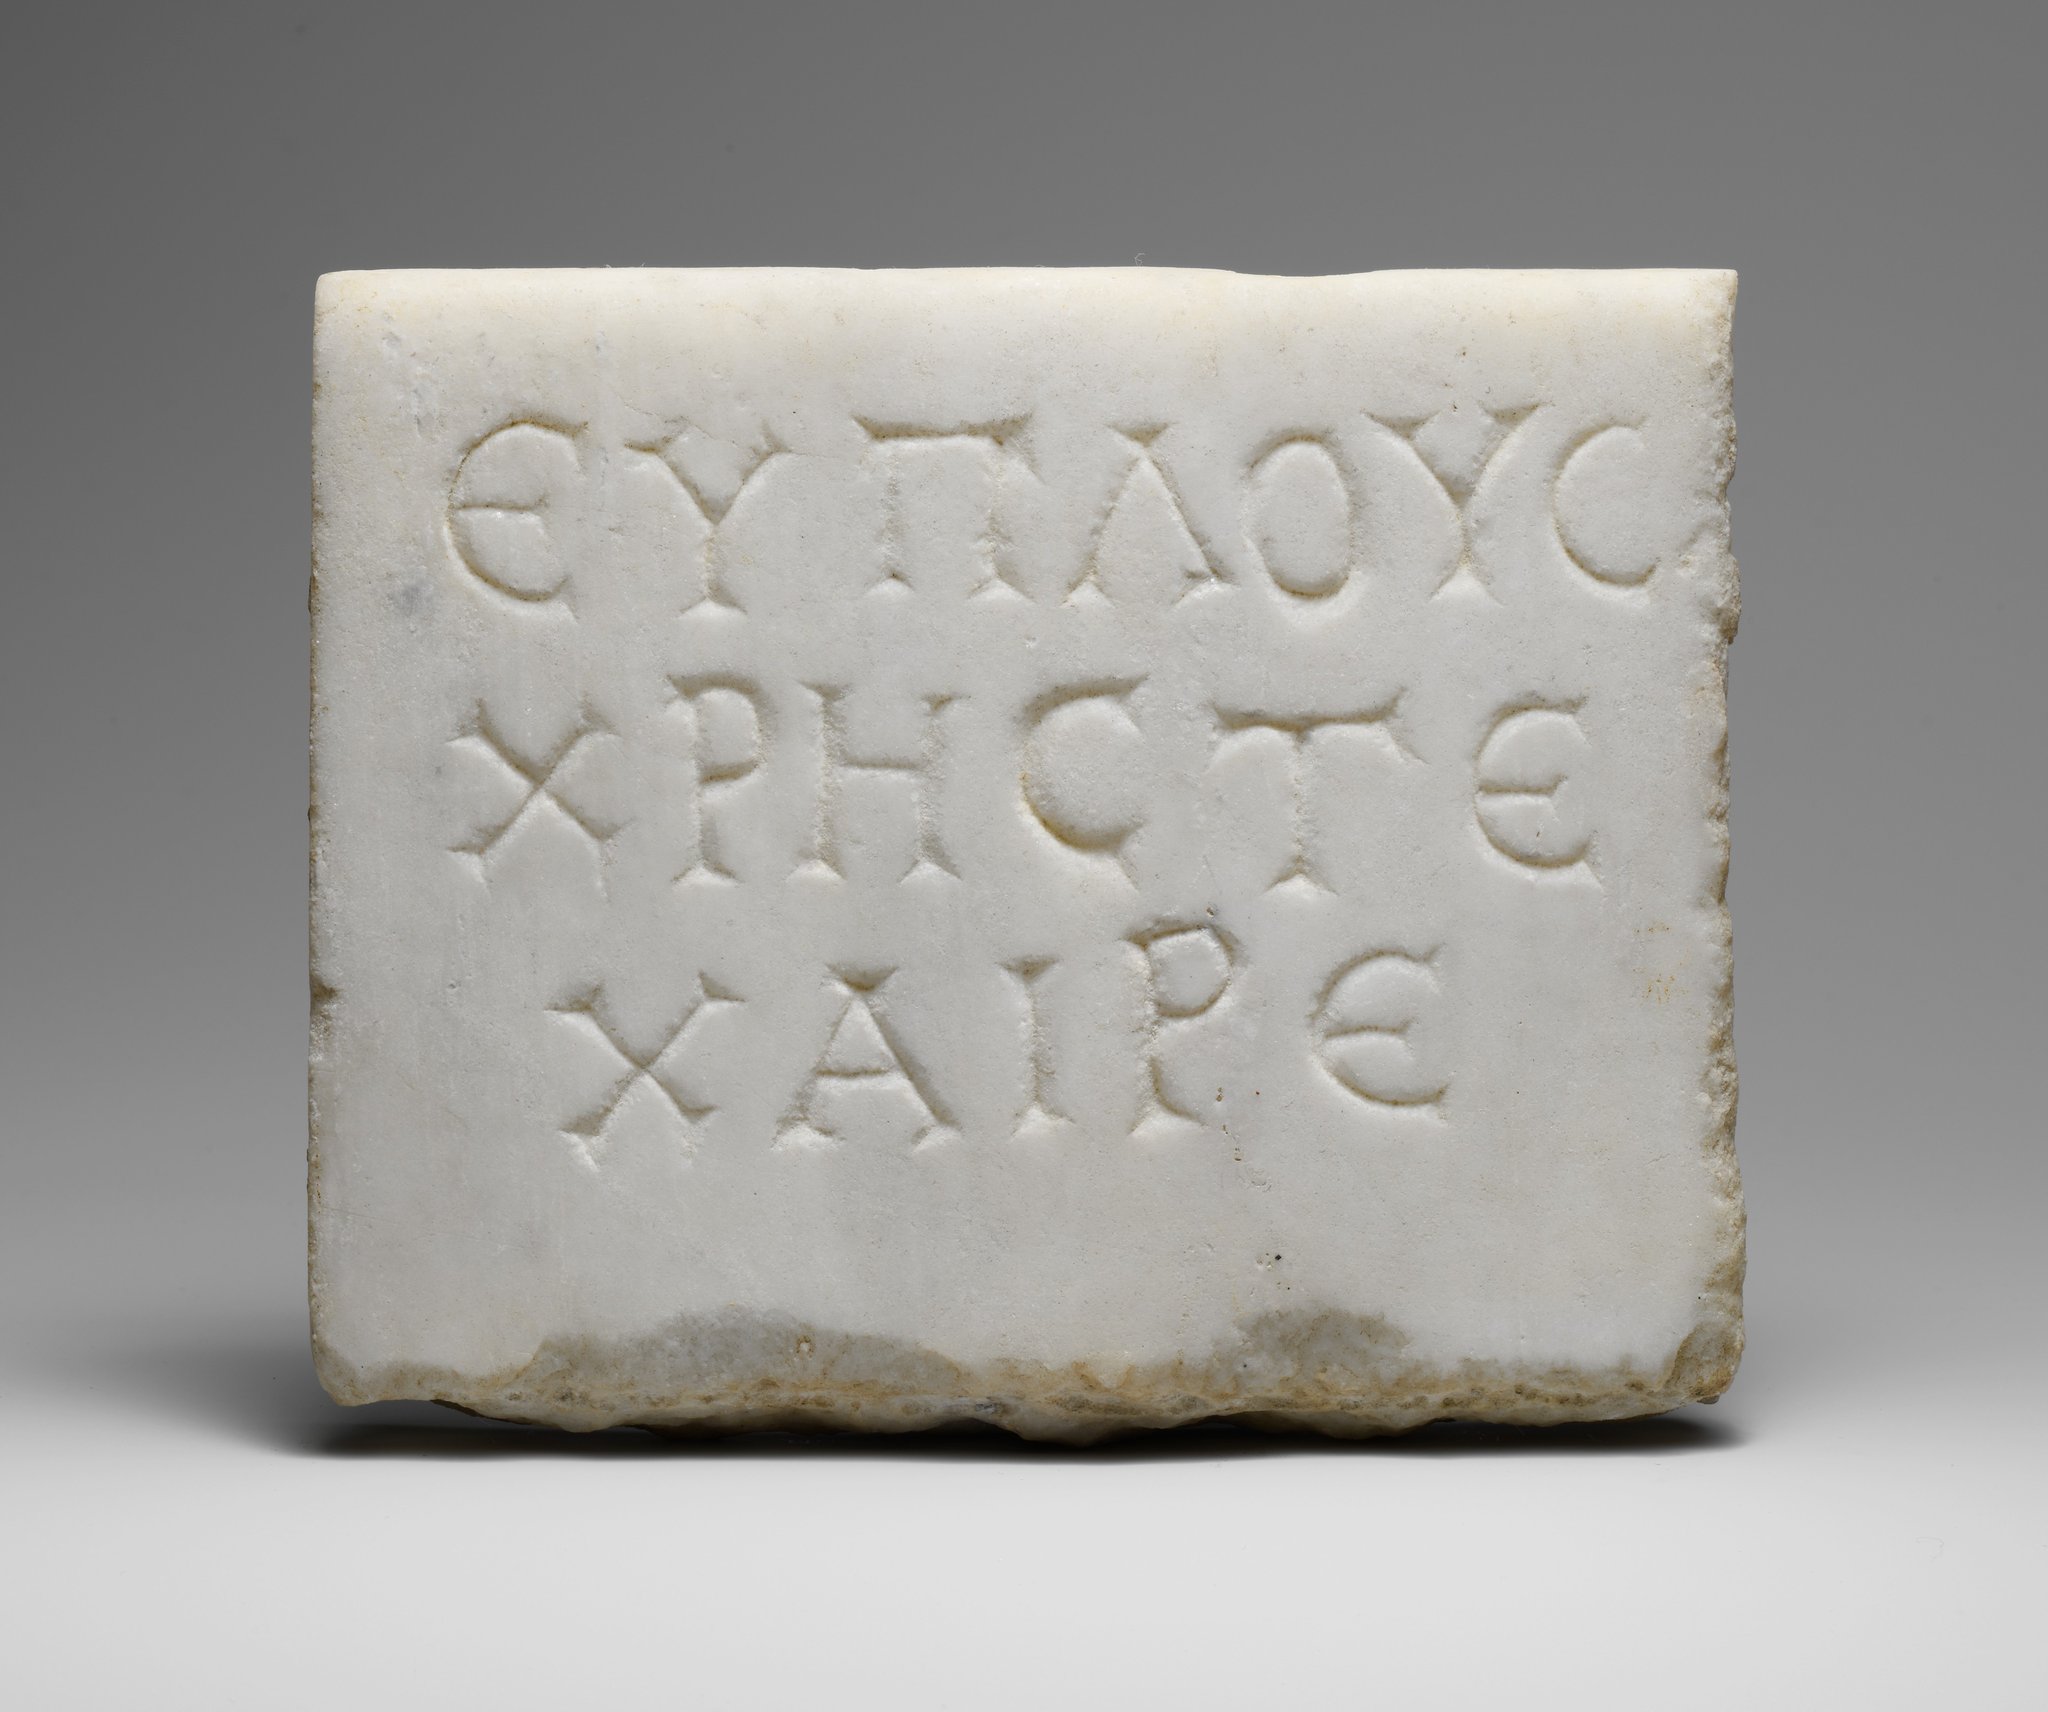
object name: tablet, sepulchral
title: Inscribed marble plaque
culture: roman, cypriot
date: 101-300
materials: marble